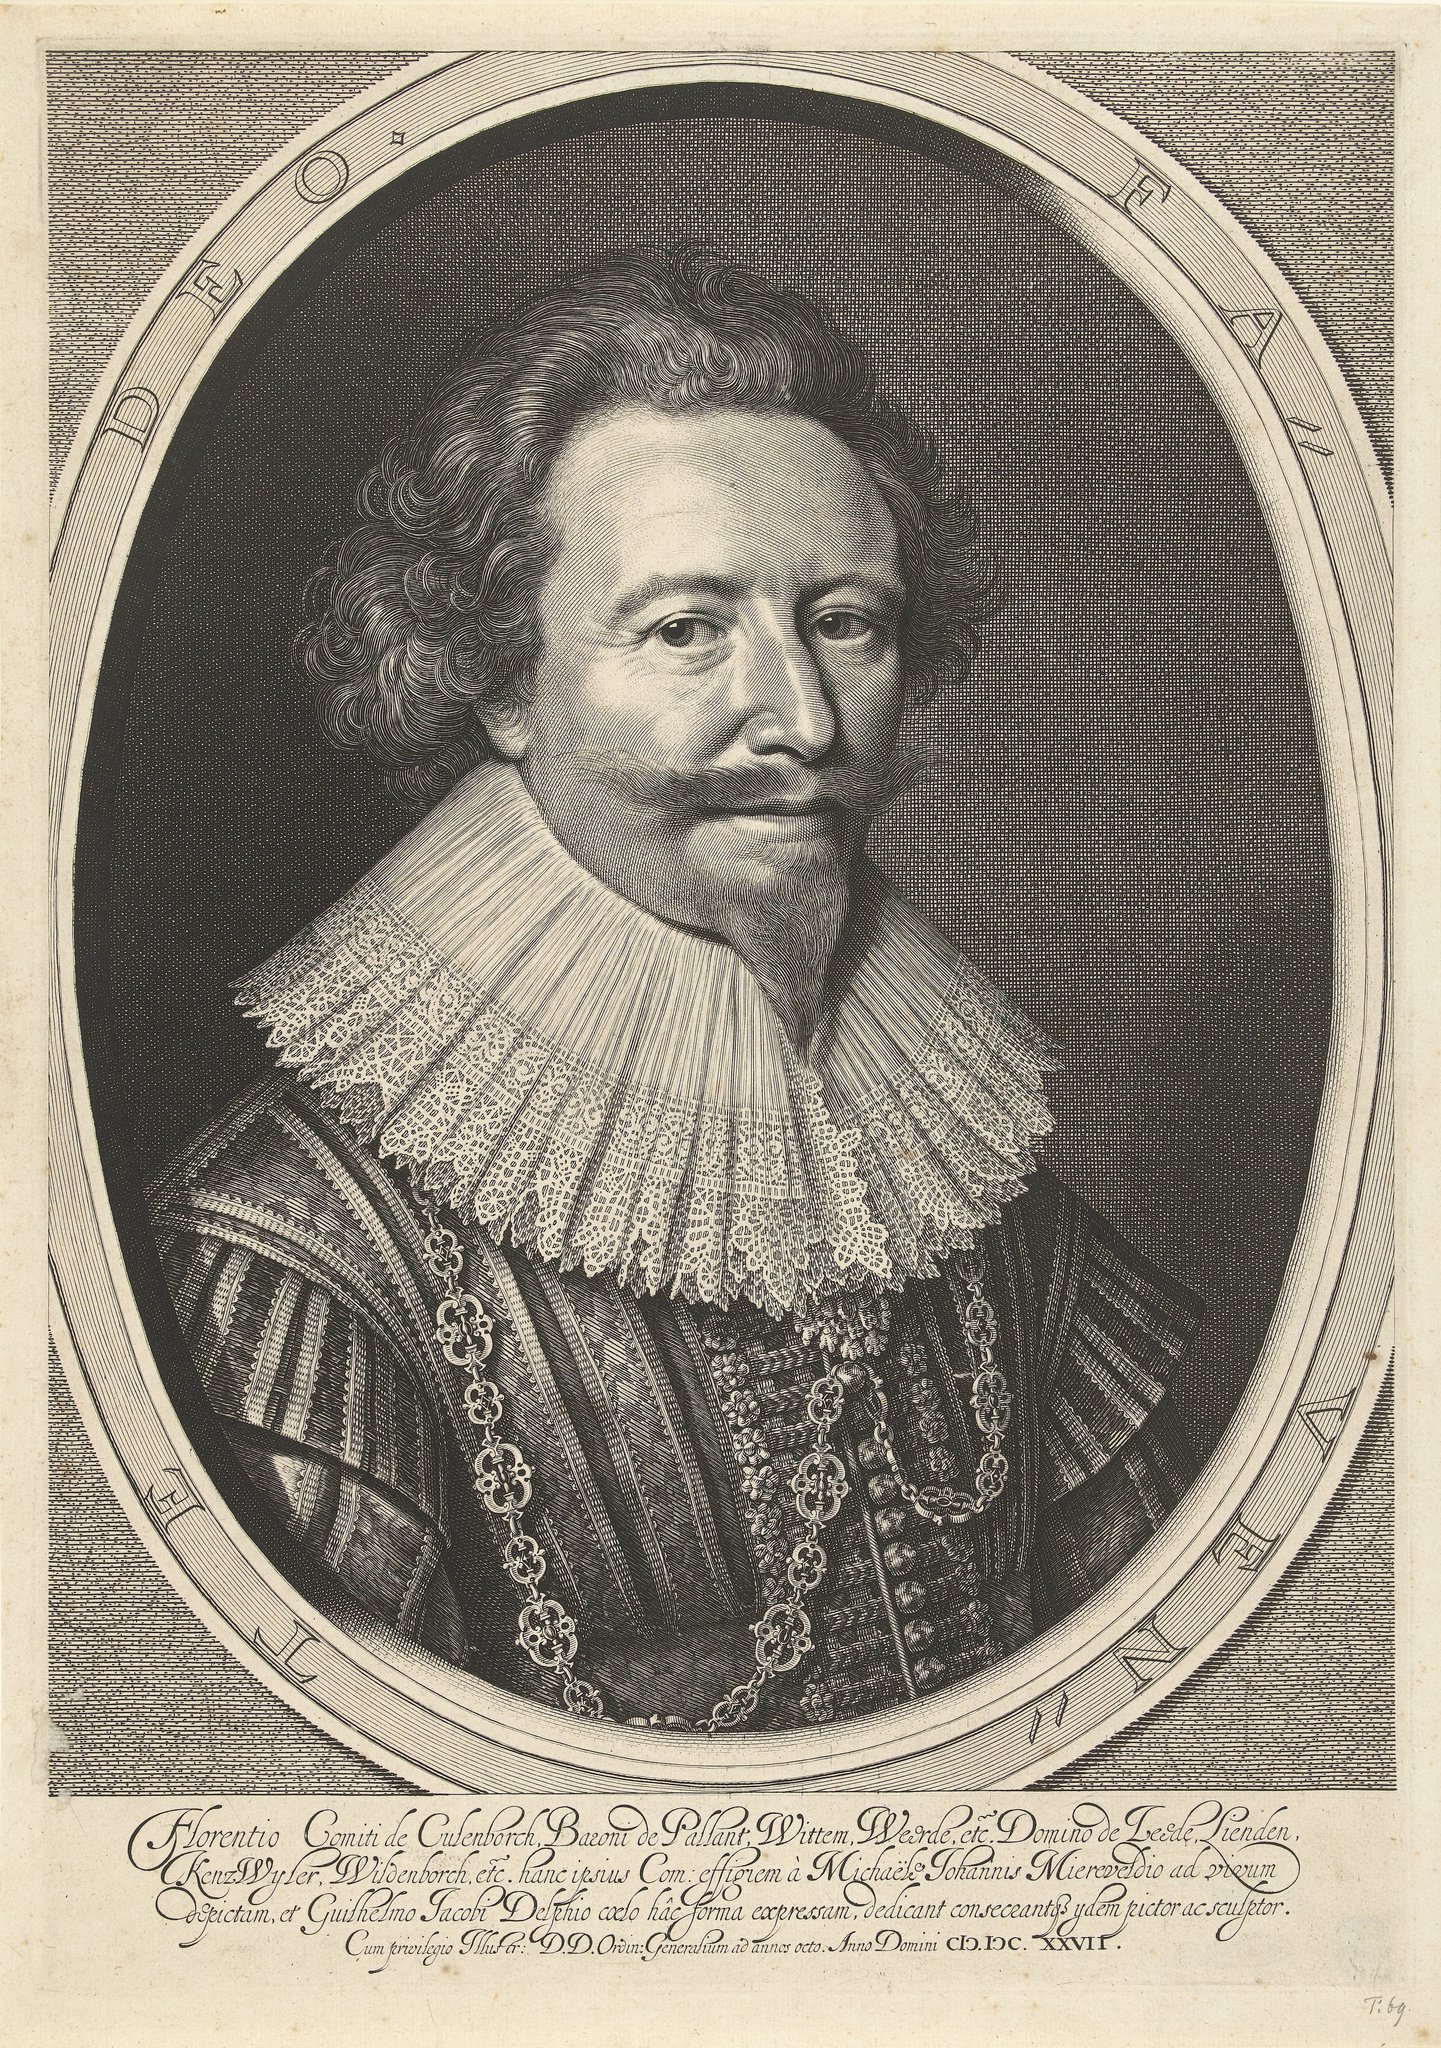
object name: print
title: Portret van Floris II, graaf van Pallandt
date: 1627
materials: paper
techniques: engraving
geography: delft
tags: earl, floris ii van pallandt (graaf van culemborg), neck-gear: collar (+ men's clothes)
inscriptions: collector's mark: Lugt 2228, collector's mark: Lugt 963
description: Portret van Floris II, graaf van Pallandt, borststuk met plooikraag en keten in ovale omlijsting met Latijns motto. In ondermarge vier regels Latijns opschrift.